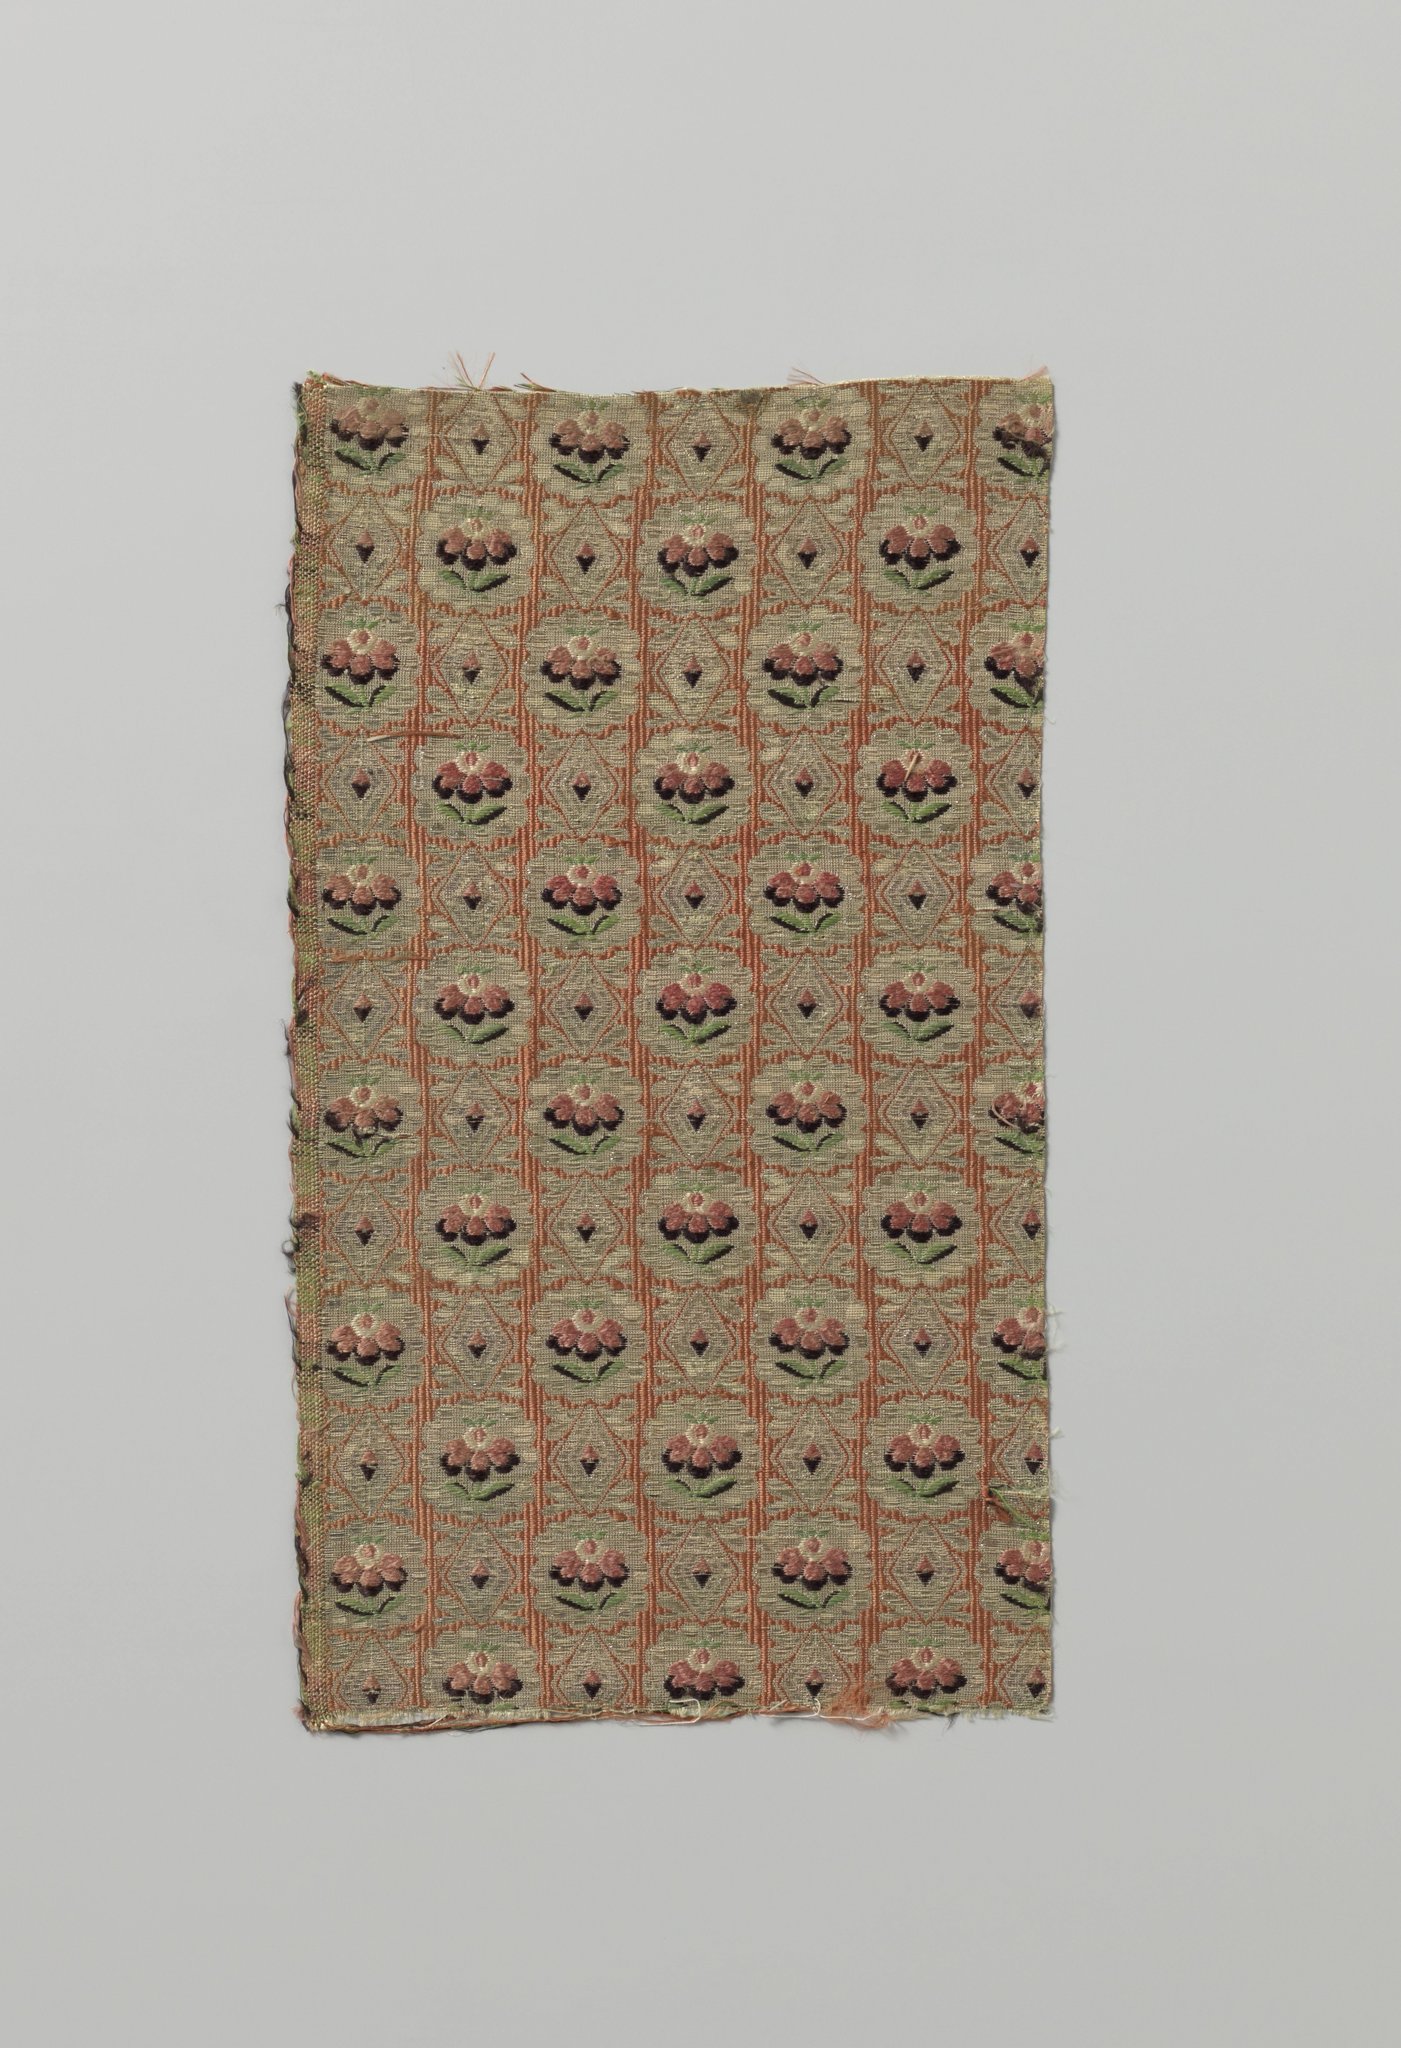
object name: fragment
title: Fragment van een veelkleurig zijdeweefsel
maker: Anonymous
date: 1750-1800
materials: silk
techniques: droguet, liseré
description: Een fragment van een zijdeweefsel met onregelmatige rode strepen, waartussen rode bloemen met zwarte omranding en rode en rood zwarte ruitvormen geweven zijn op een zilver doorweven grond. Opmerking: Zelfkant; 0.7 cm effenbinding (meerdere kleuren in één sprong.